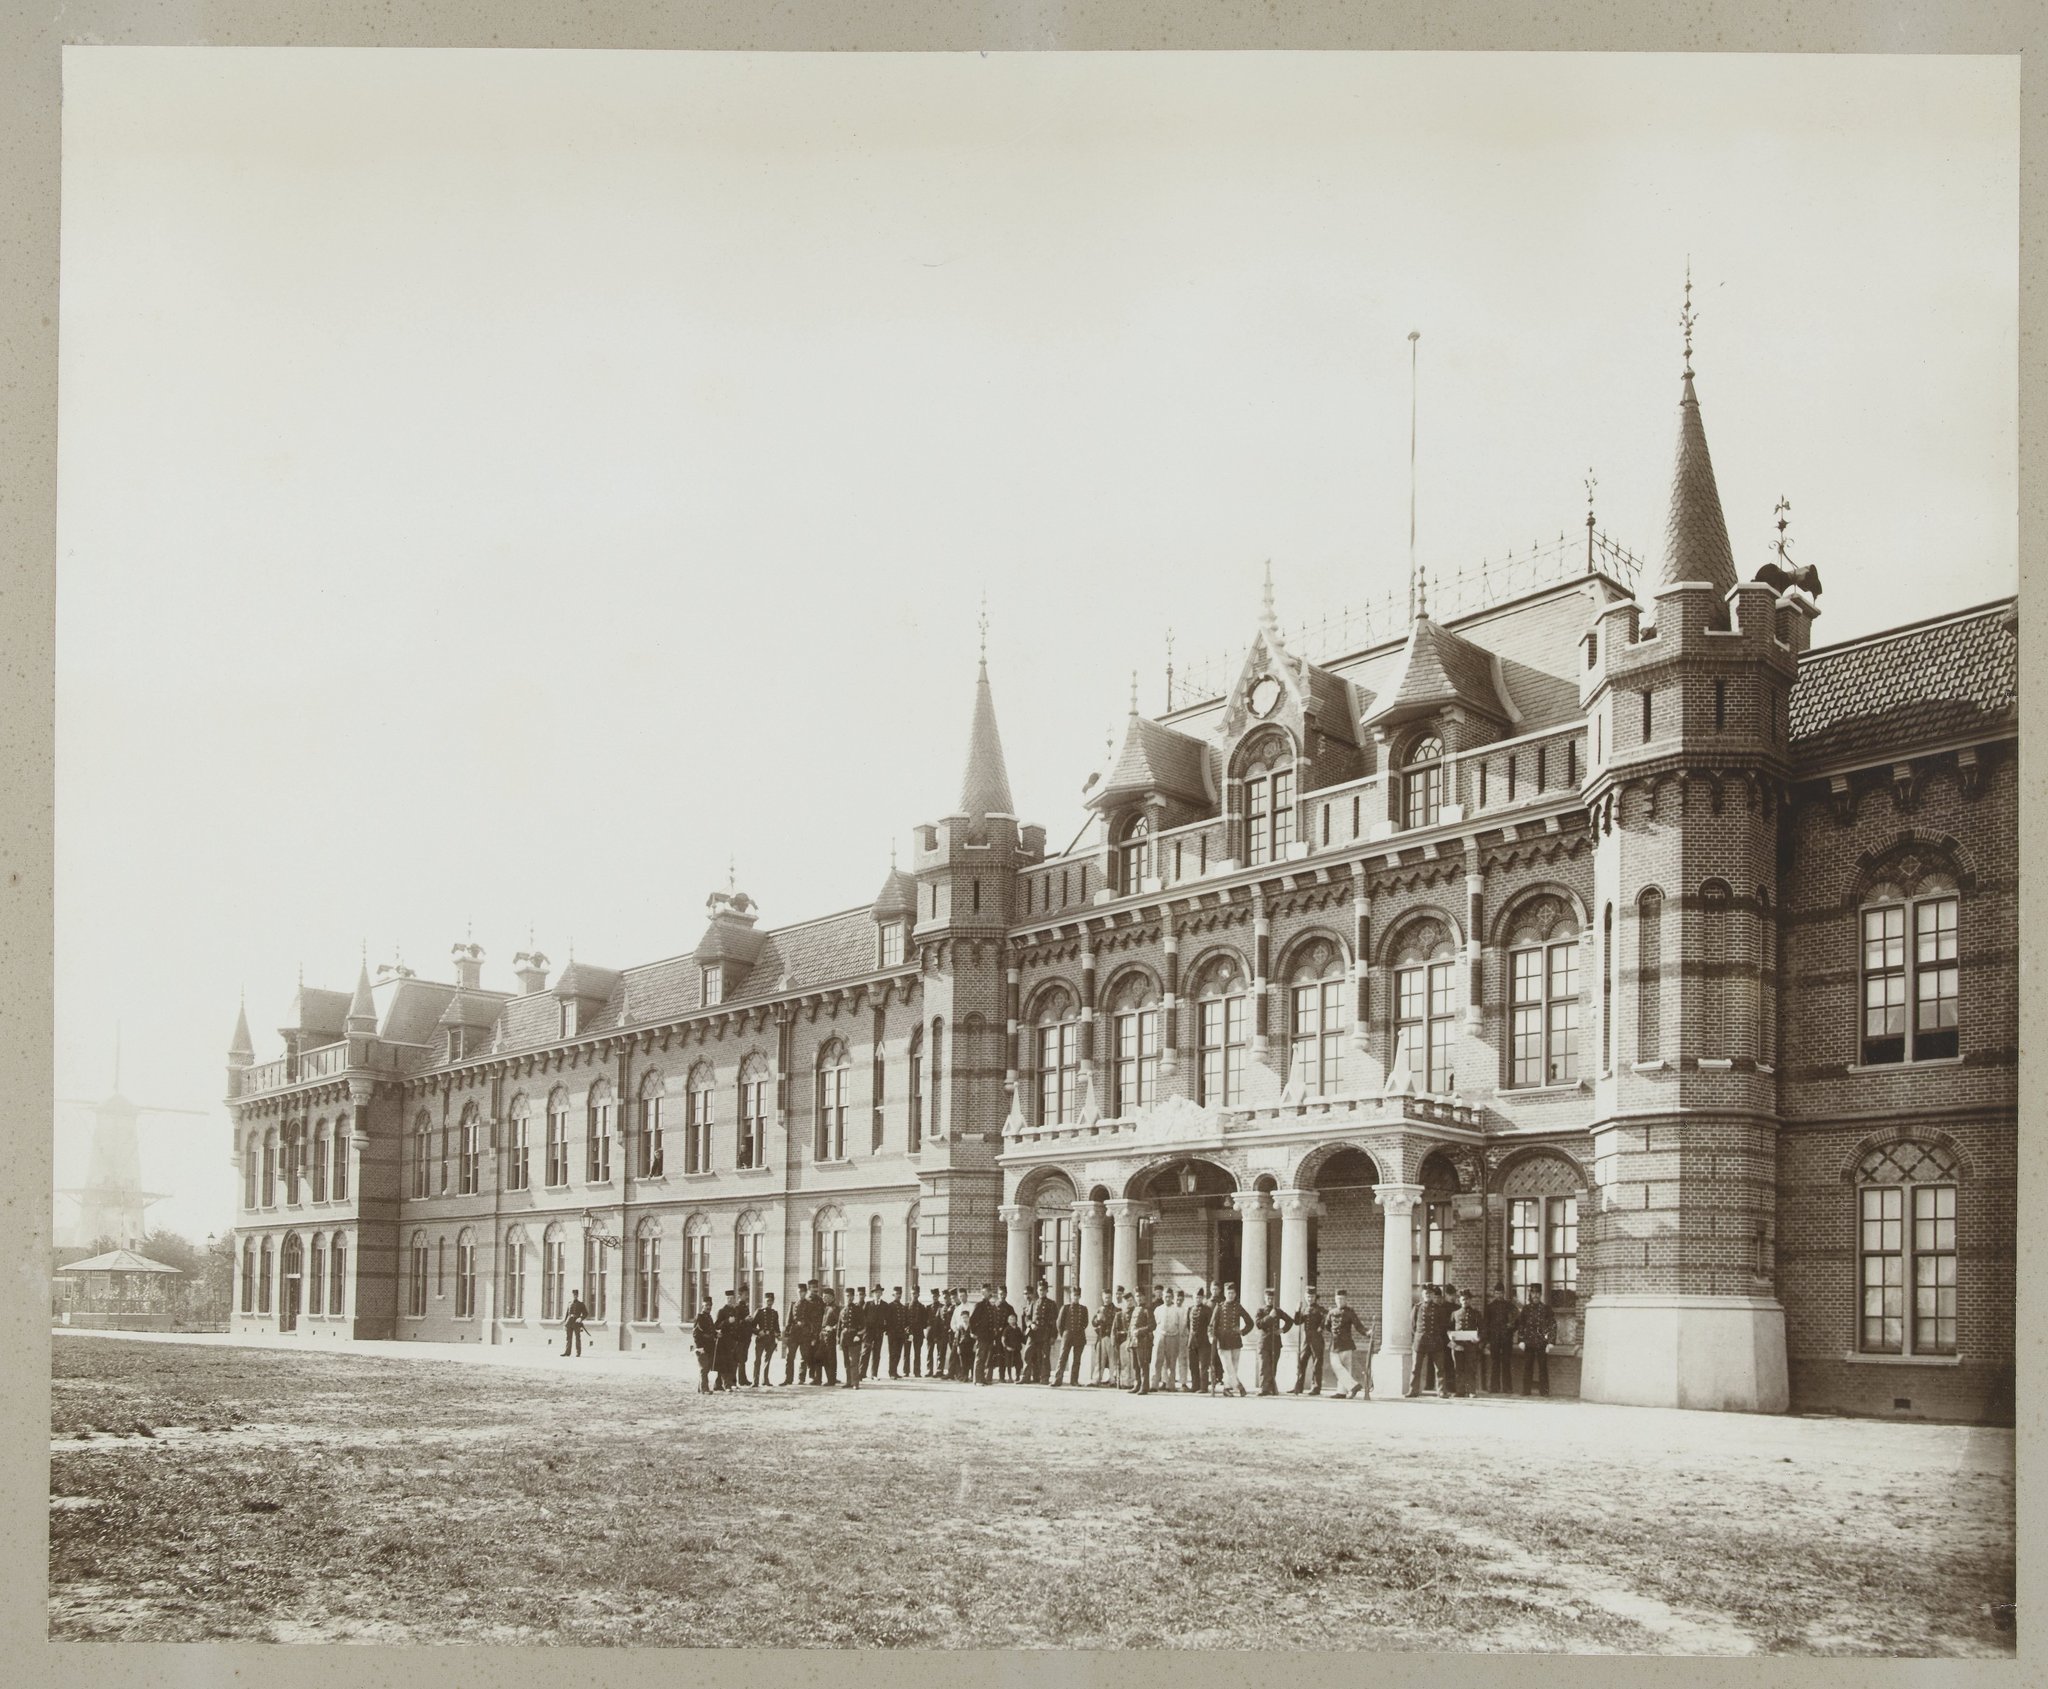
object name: photograph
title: Chassékazerne te Breda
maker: Anonymous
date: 1890-1910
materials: cardboard, photographic support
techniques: collodion silver print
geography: netherlands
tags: breda